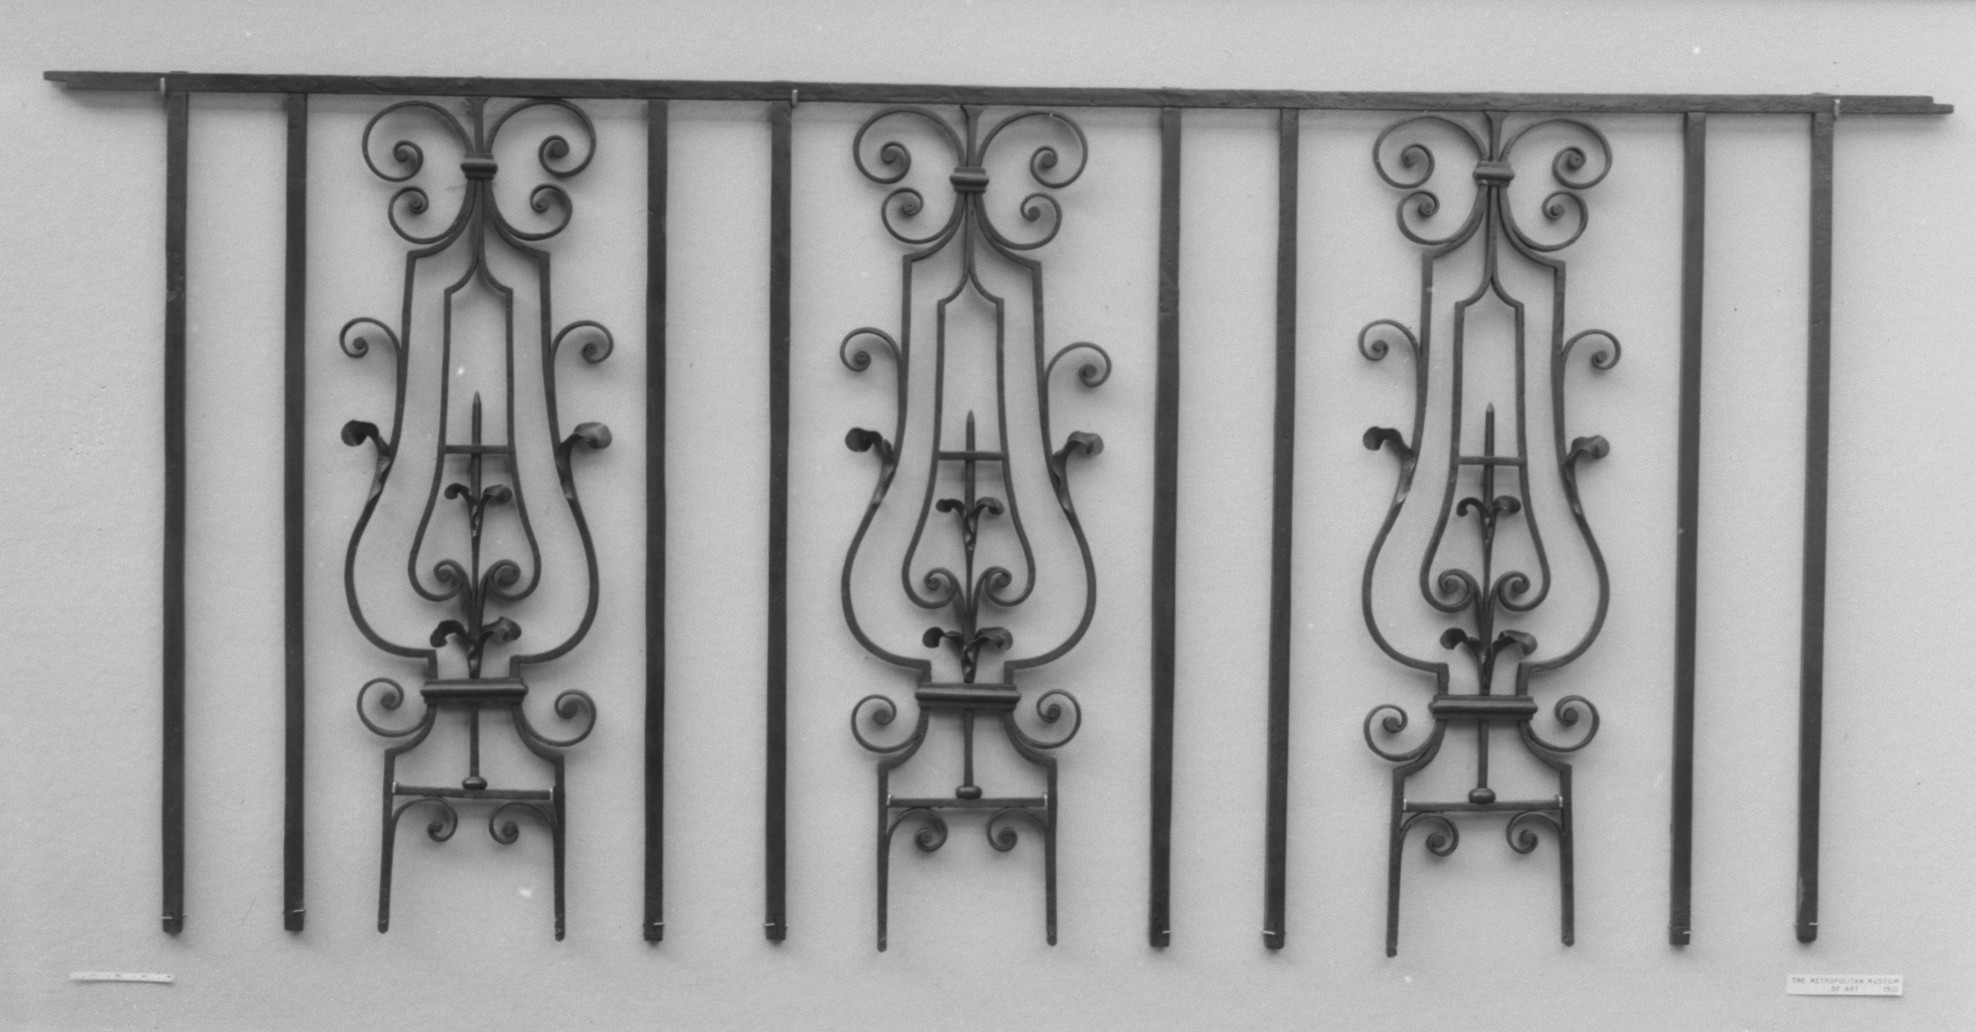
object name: baluster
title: Set of three balusters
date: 1760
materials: iron